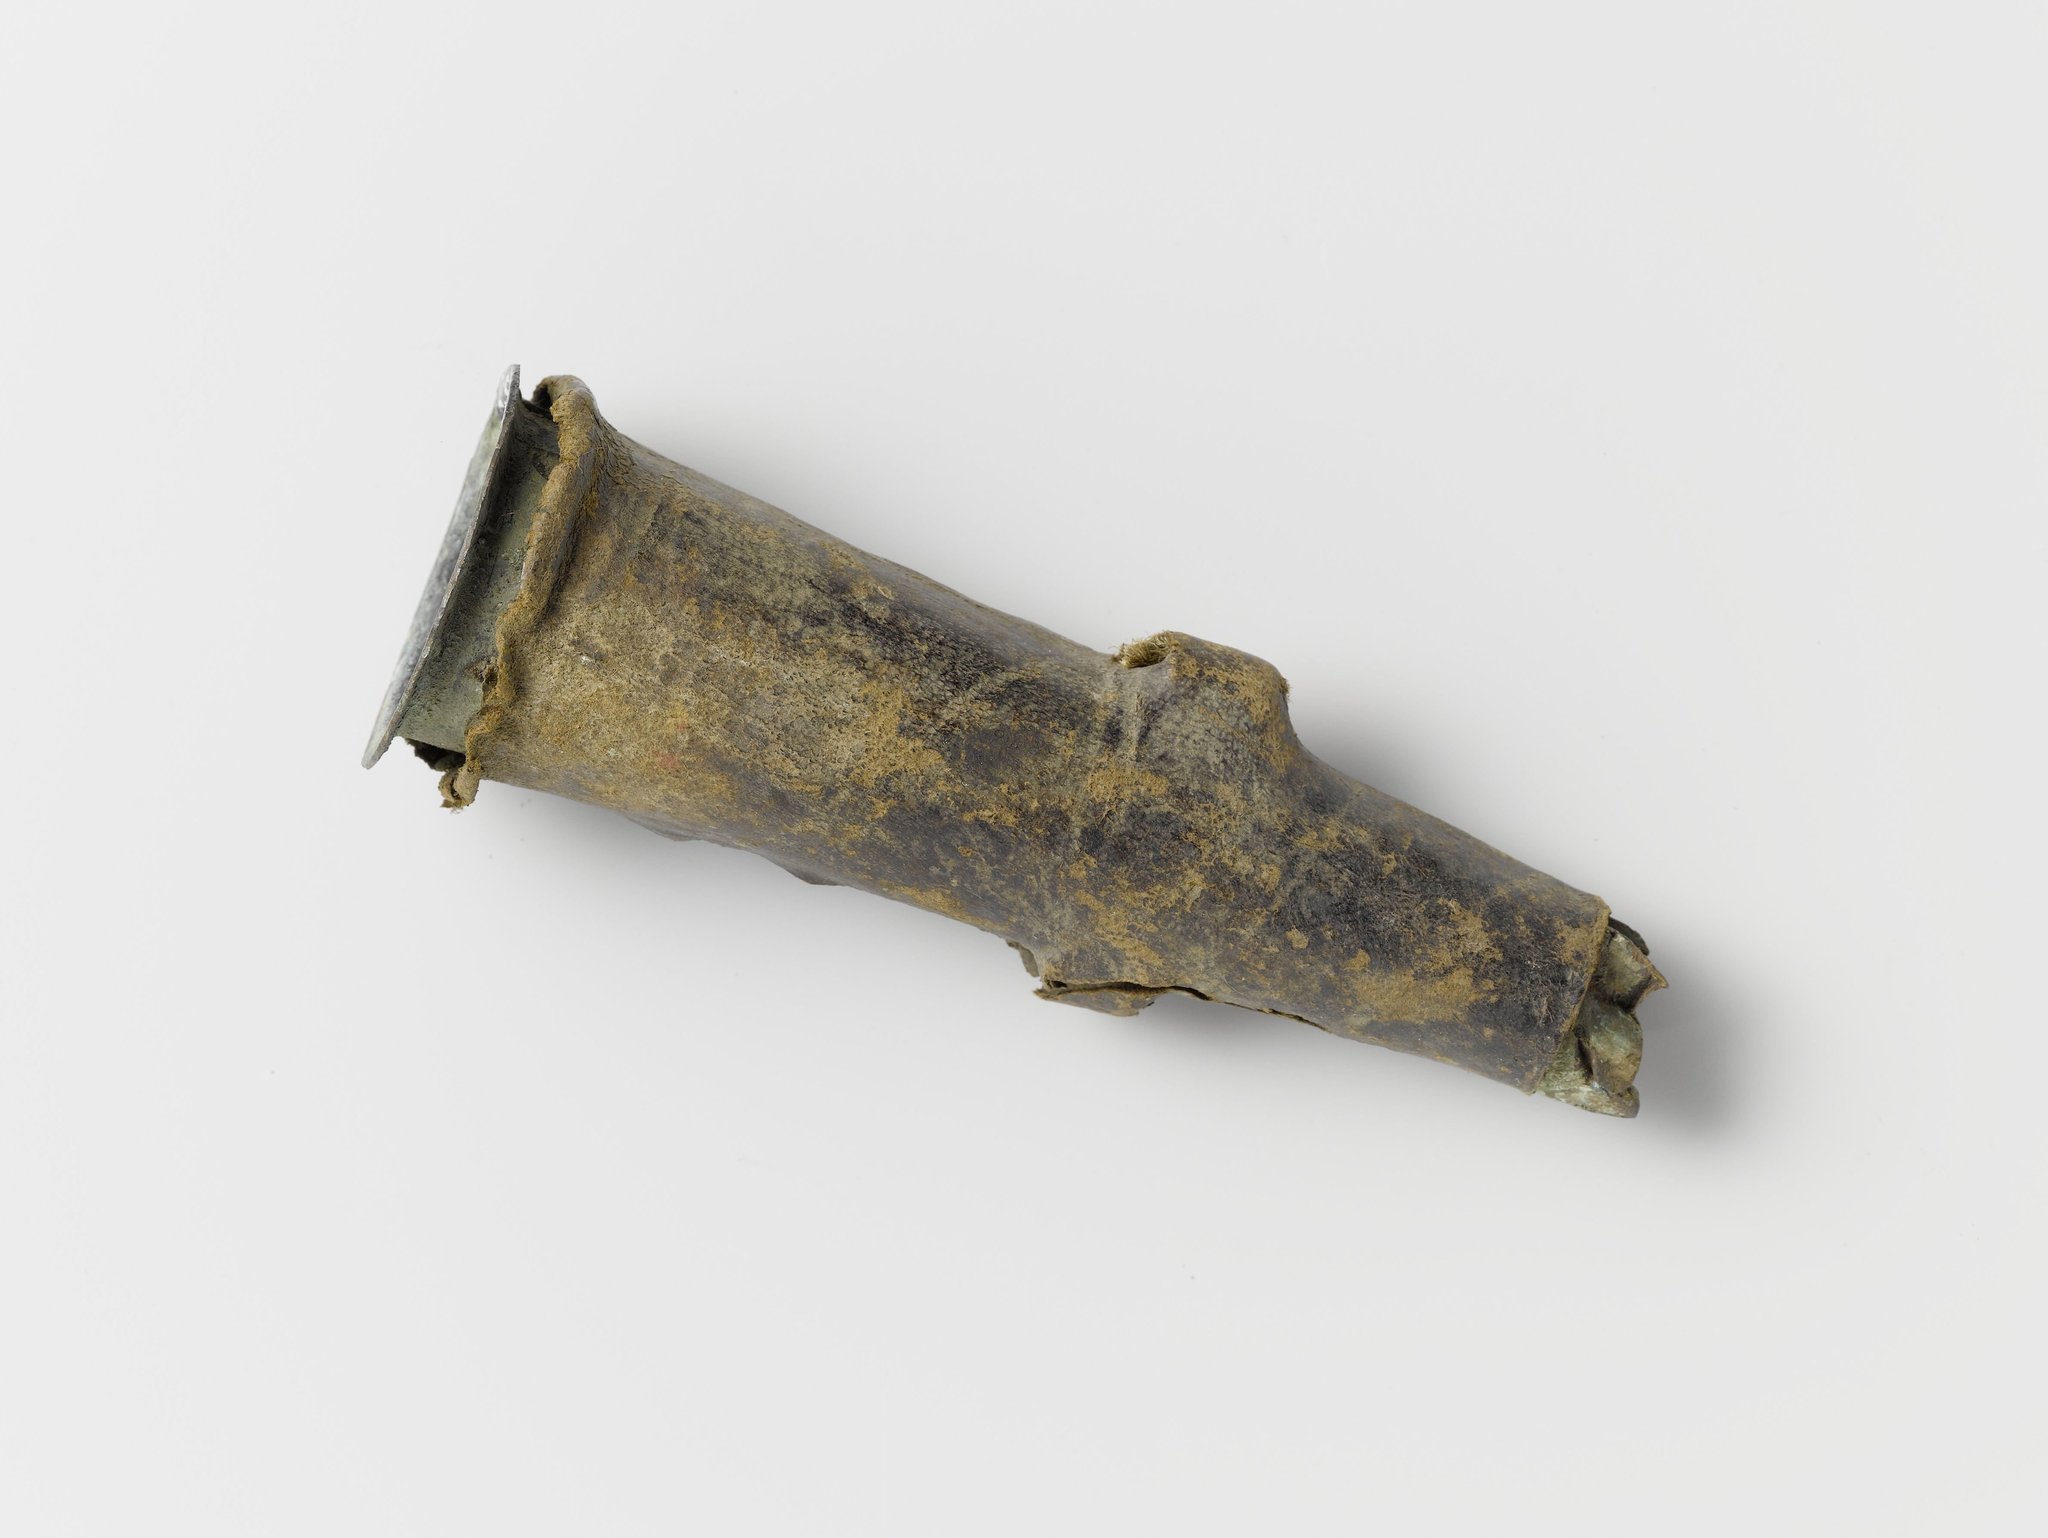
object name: kruitmaat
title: Fragment van een musketmaat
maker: Anonymous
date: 1590-1596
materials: brass, leather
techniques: striking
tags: willem barendsz., amsterdam, jacob van heemskerck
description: Musketmaat, fragment bestaande uit messing en leren huls met oortjes, zonder onderkant en met vervormde bovenkant. Standaardbeschrijving musketmaat: messing met leder bekleed. Voorzien van twee oogjes aan de zijkant om een koord door te doen waarmee de deksel werd vastgehouden en het maatje aan de bandelier werd gehangen. Een muskettiersbandelier had twaalf kruitmaatjes en een zakje met kogels. De kruitmaatjes bevatten een zorgvuldig afgepaste hoeveelheid buskruit voor één schot.